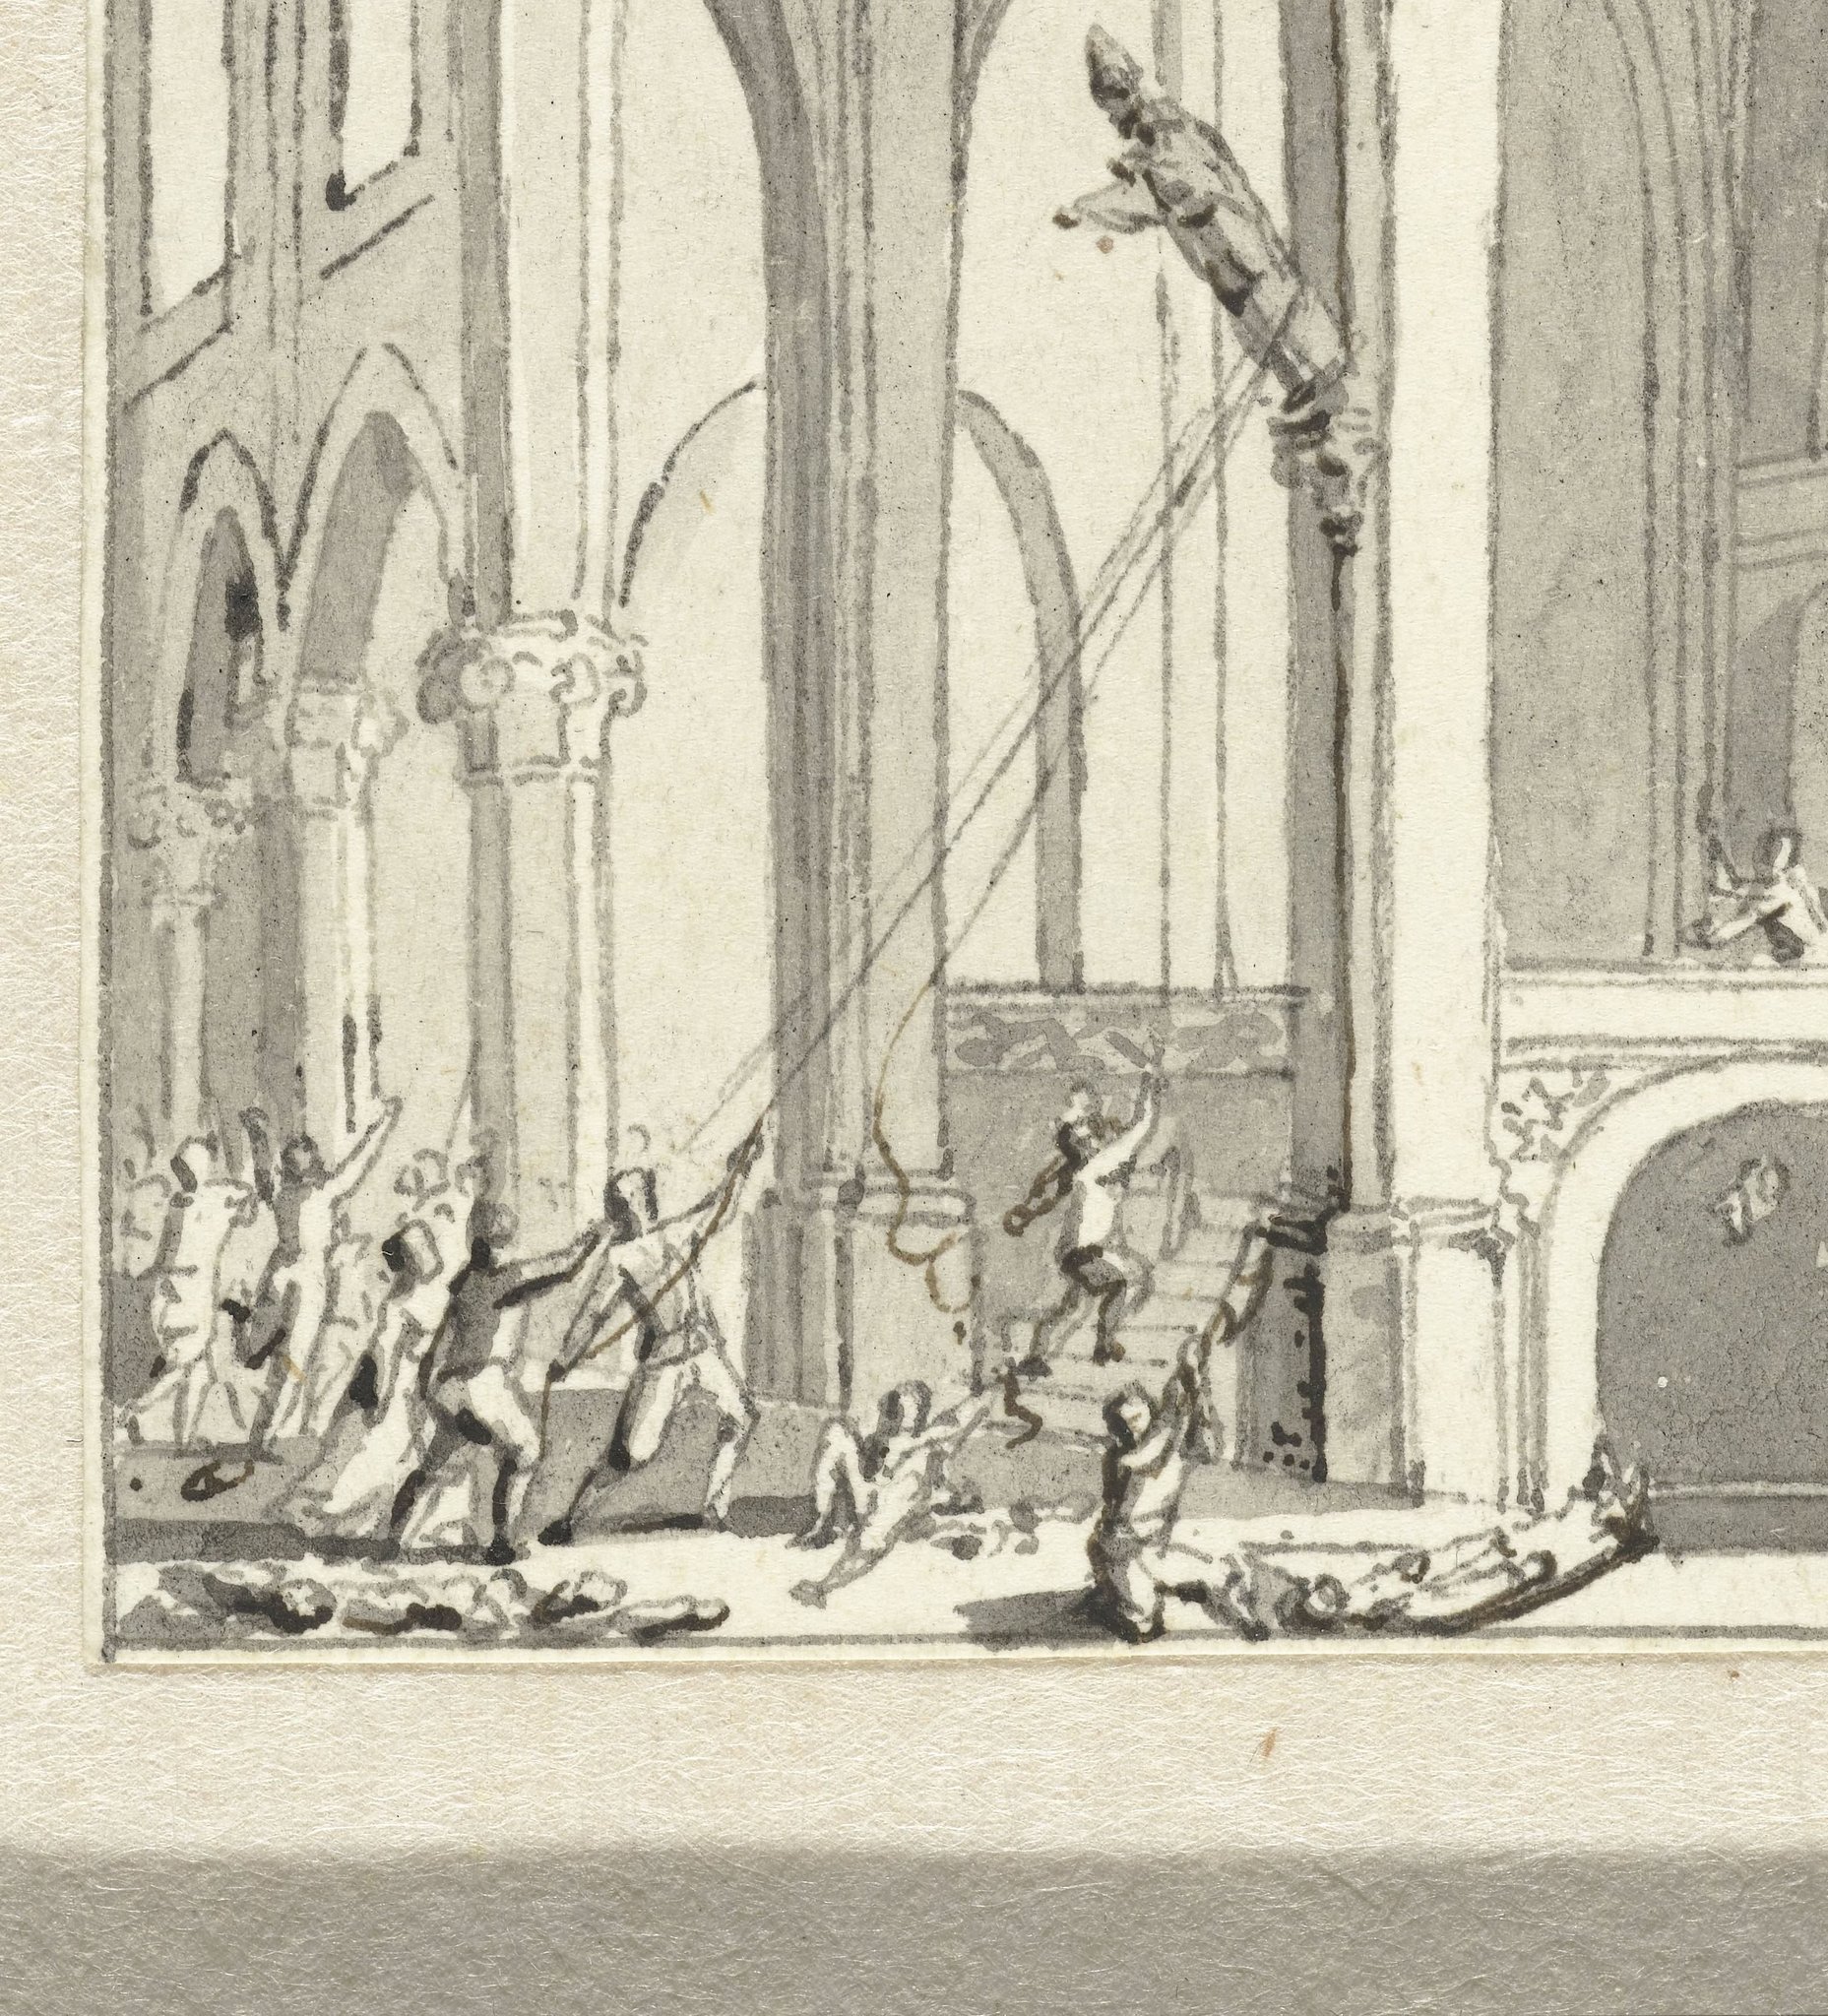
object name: design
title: In 't Jaar 1566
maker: Anonymous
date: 1789-1810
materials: ink, paper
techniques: brush, pen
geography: netherlands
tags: iconoclasm, beeldenstorm (1566)